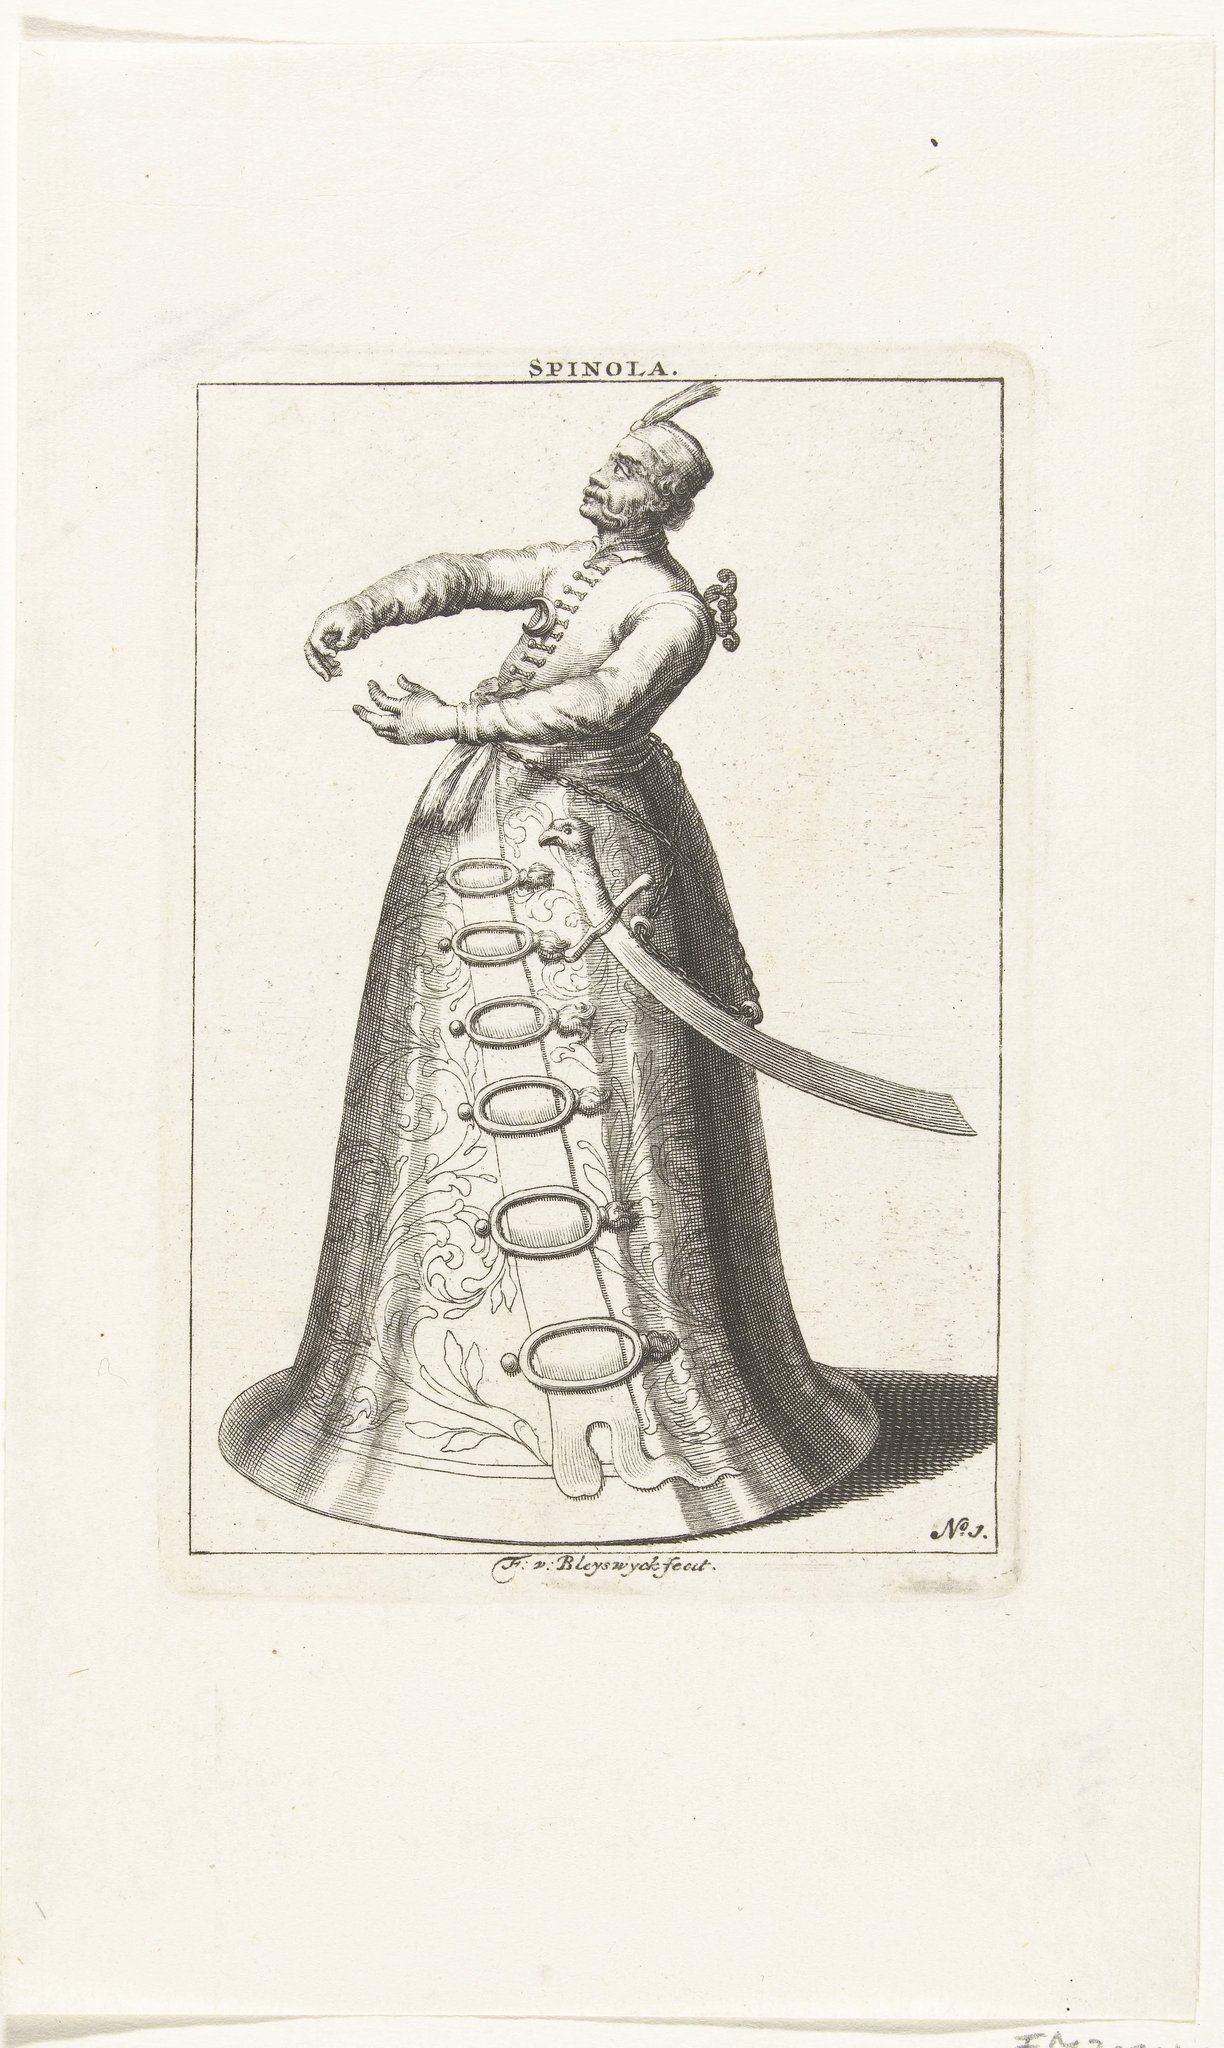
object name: print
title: Spinola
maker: françois van bleyswijck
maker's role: draughtsman, print maker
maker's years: 1671-1746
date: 1732-1735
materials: paper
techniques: etching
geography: northern netherlands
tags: glass, rummer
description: Gebruikt als illustratie in: Cornelis van Alkemade, Nederlands displegtigheden, vertoonende de plegtige gebruiken aan den dis (...) onder de (...) ingezetenen der Nederlanden, weleer gebruikelyk, 3 dln, Philippus Losel, Rotterdam, 1732-1735, dl. 3 (1735), p. 480/481.